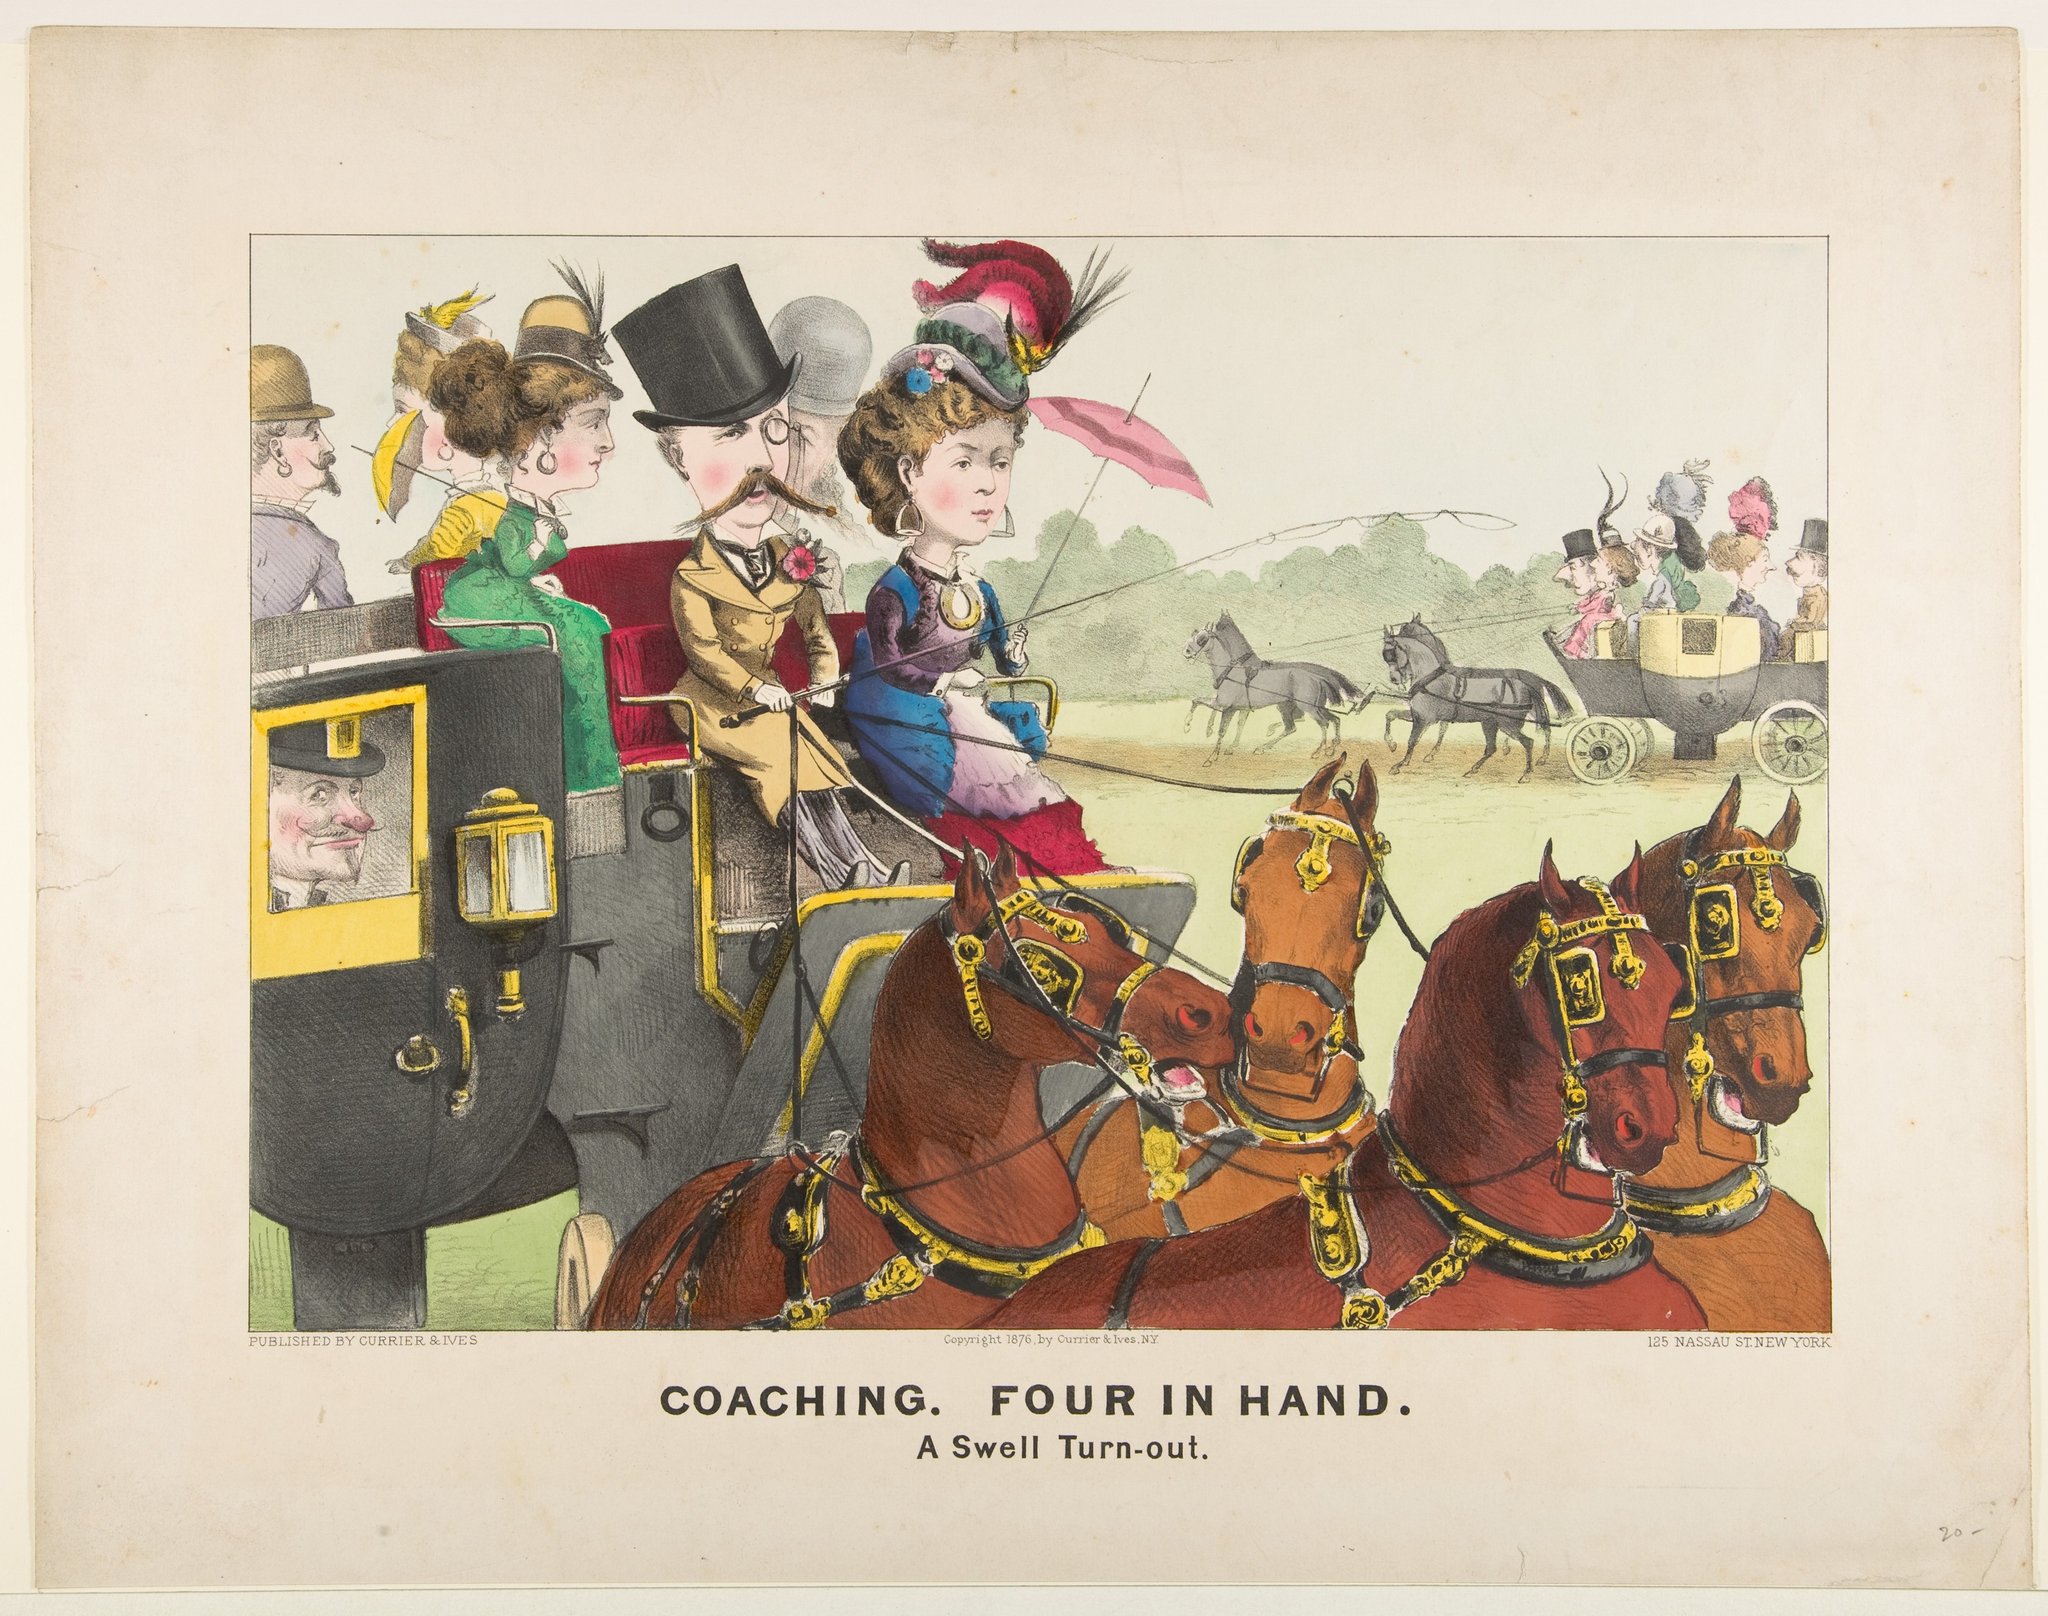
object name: print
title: Coaching – Four in Hand – A Swell Turn-out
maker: currier & ives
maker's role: publisher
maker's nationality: american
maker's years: 1857-1907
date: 1876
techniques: hand coloring, lithograph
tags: men,women,horses,carriages